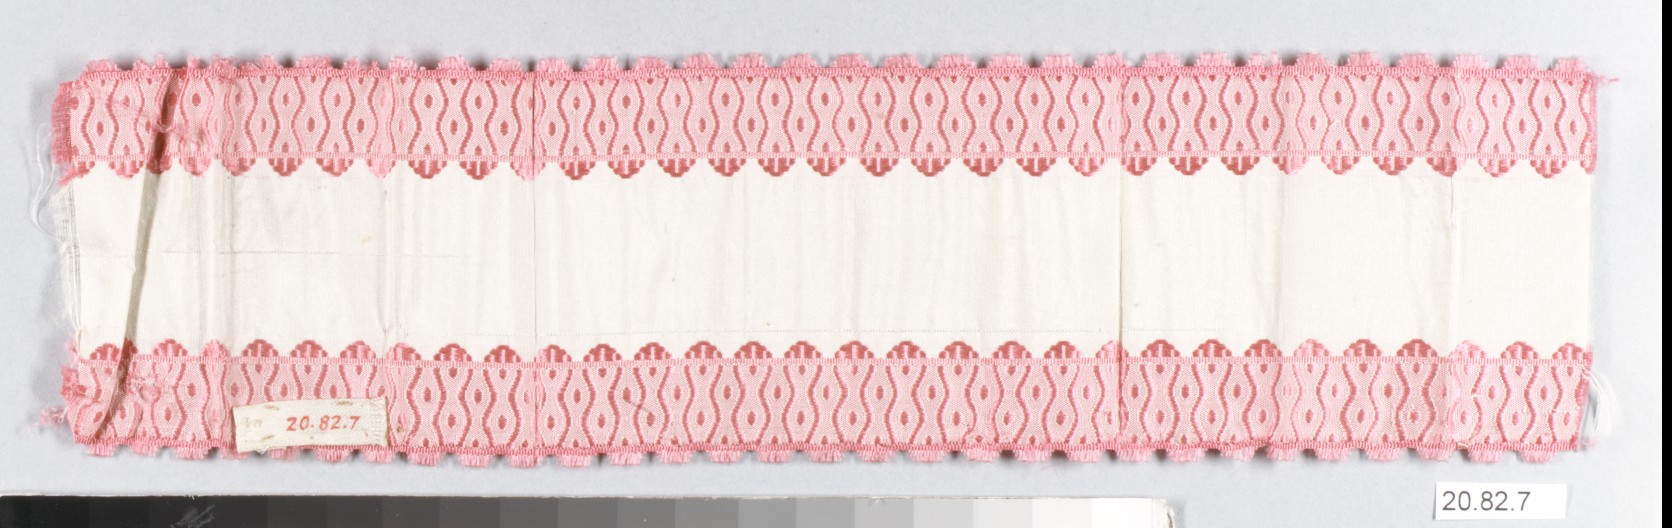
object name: ribbon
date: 1801-1833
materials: silk